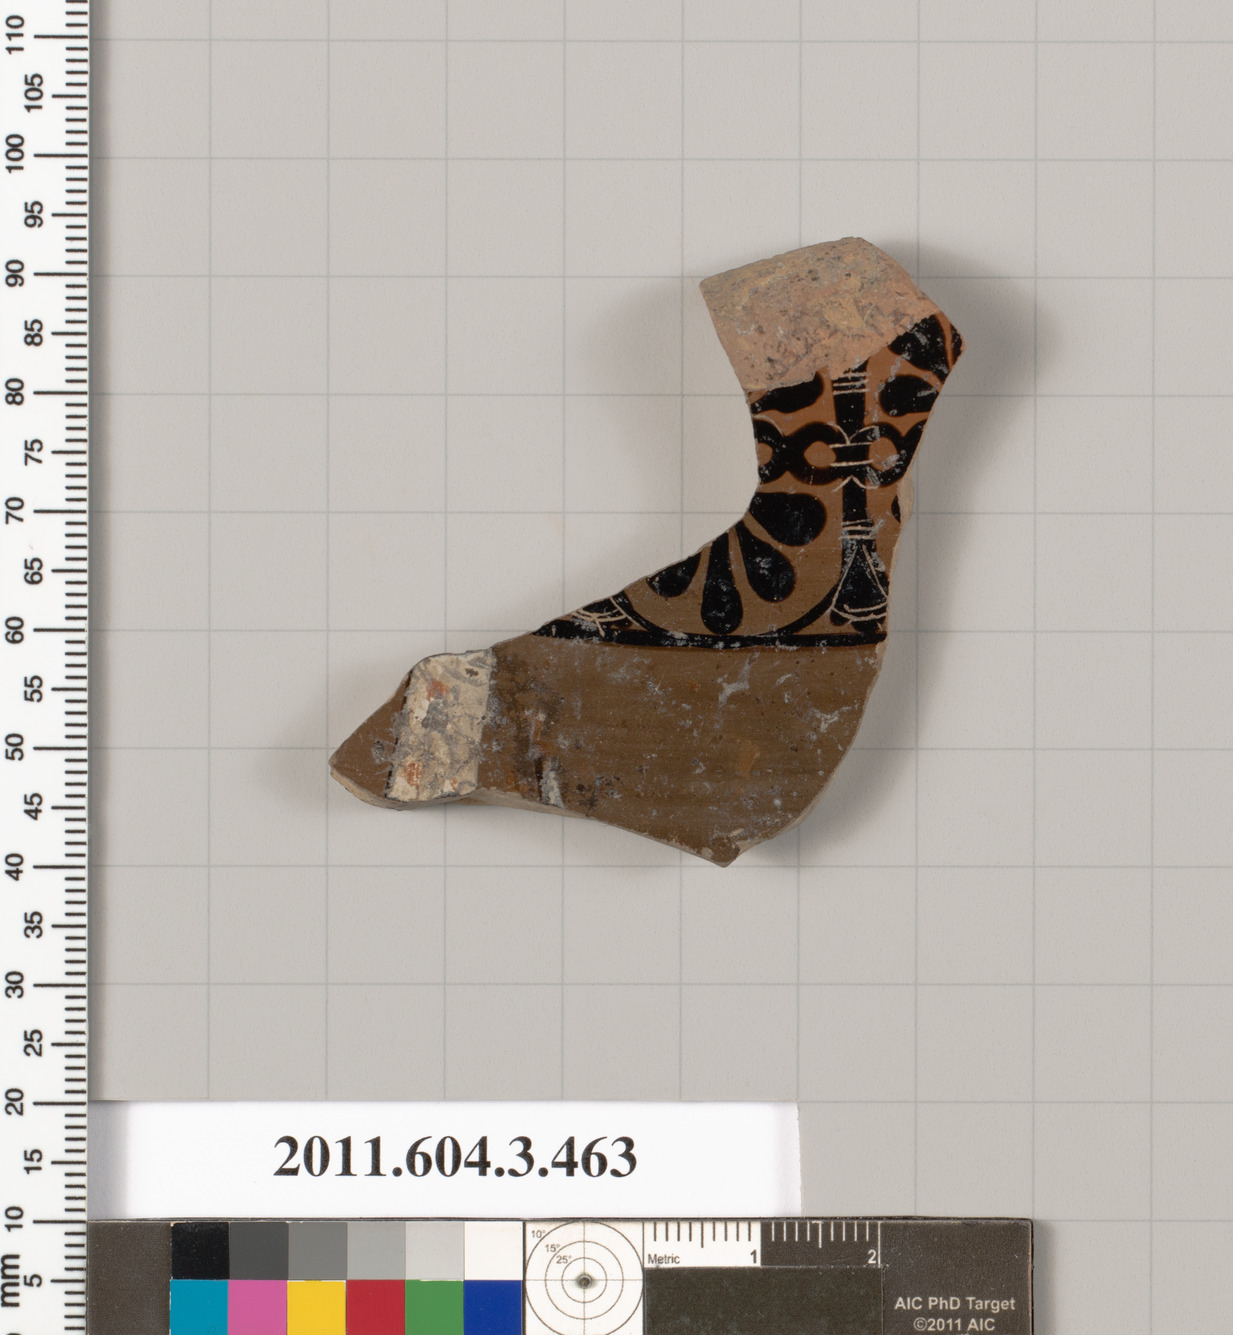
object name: amphora fragment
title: Terracotta fragment of an amphora (jar)?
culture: greek, attic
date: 525-501 BCE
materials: terracotta